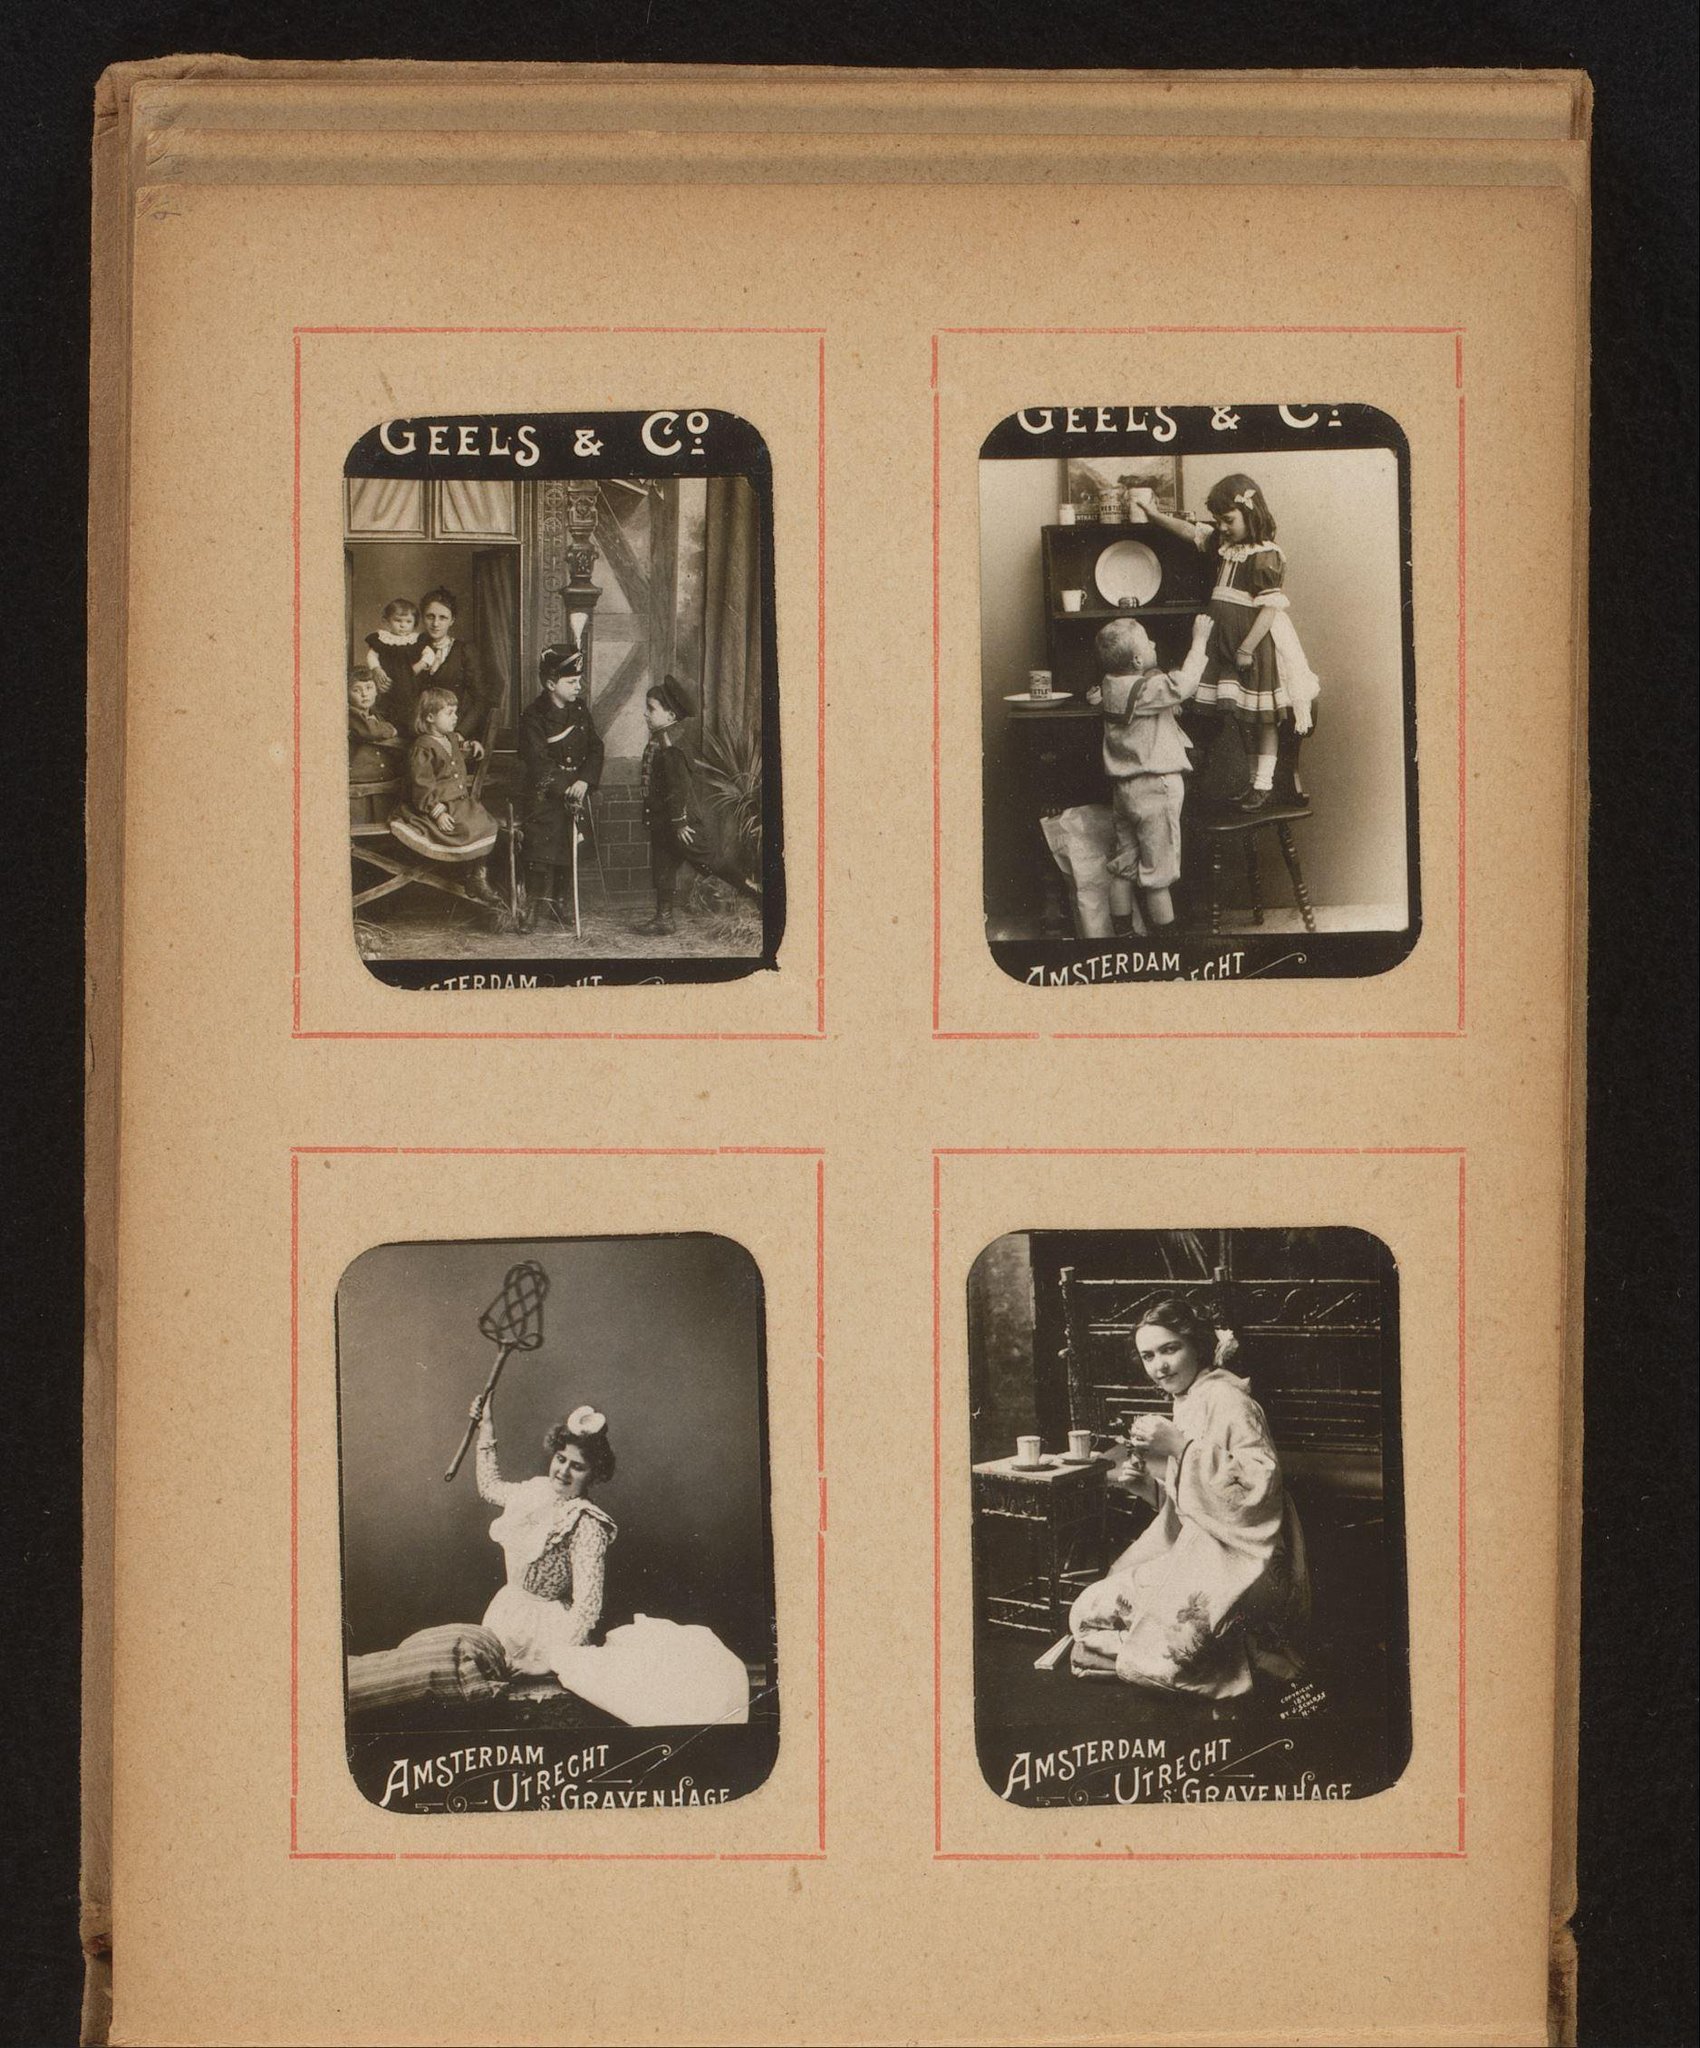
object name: photograph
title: Kinderportretten en een portret van een jonge vrouw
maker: Anonymous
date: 1880-1920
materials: paper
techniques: gelatin silver print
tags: child, household chores, trade games, imitative games, imitating adults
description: Drie portretten van kinderen met het opschrift Geels& Co. Amsterdam Utrecht & 's Gravenhage en een portret van een jonge vrouw met een mattenklopper. Deze pagina maakt deel uit van een album.